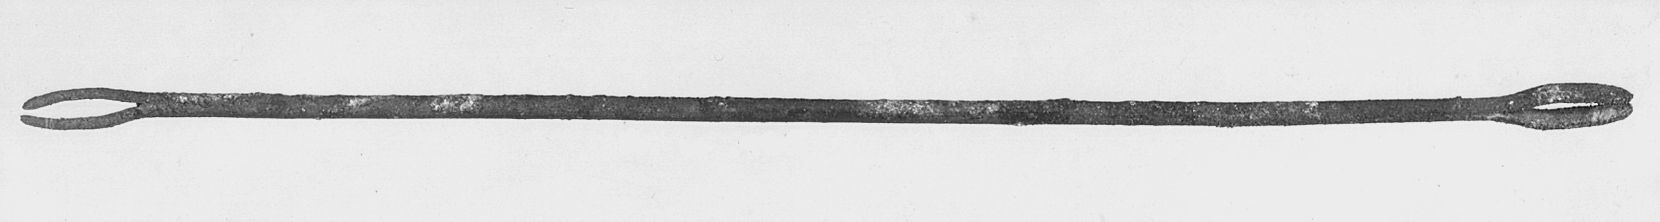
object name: weaving needle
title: Needle Used For Making Nets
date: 1550-1458 BCE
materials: bronze, copper alloy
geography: egypt